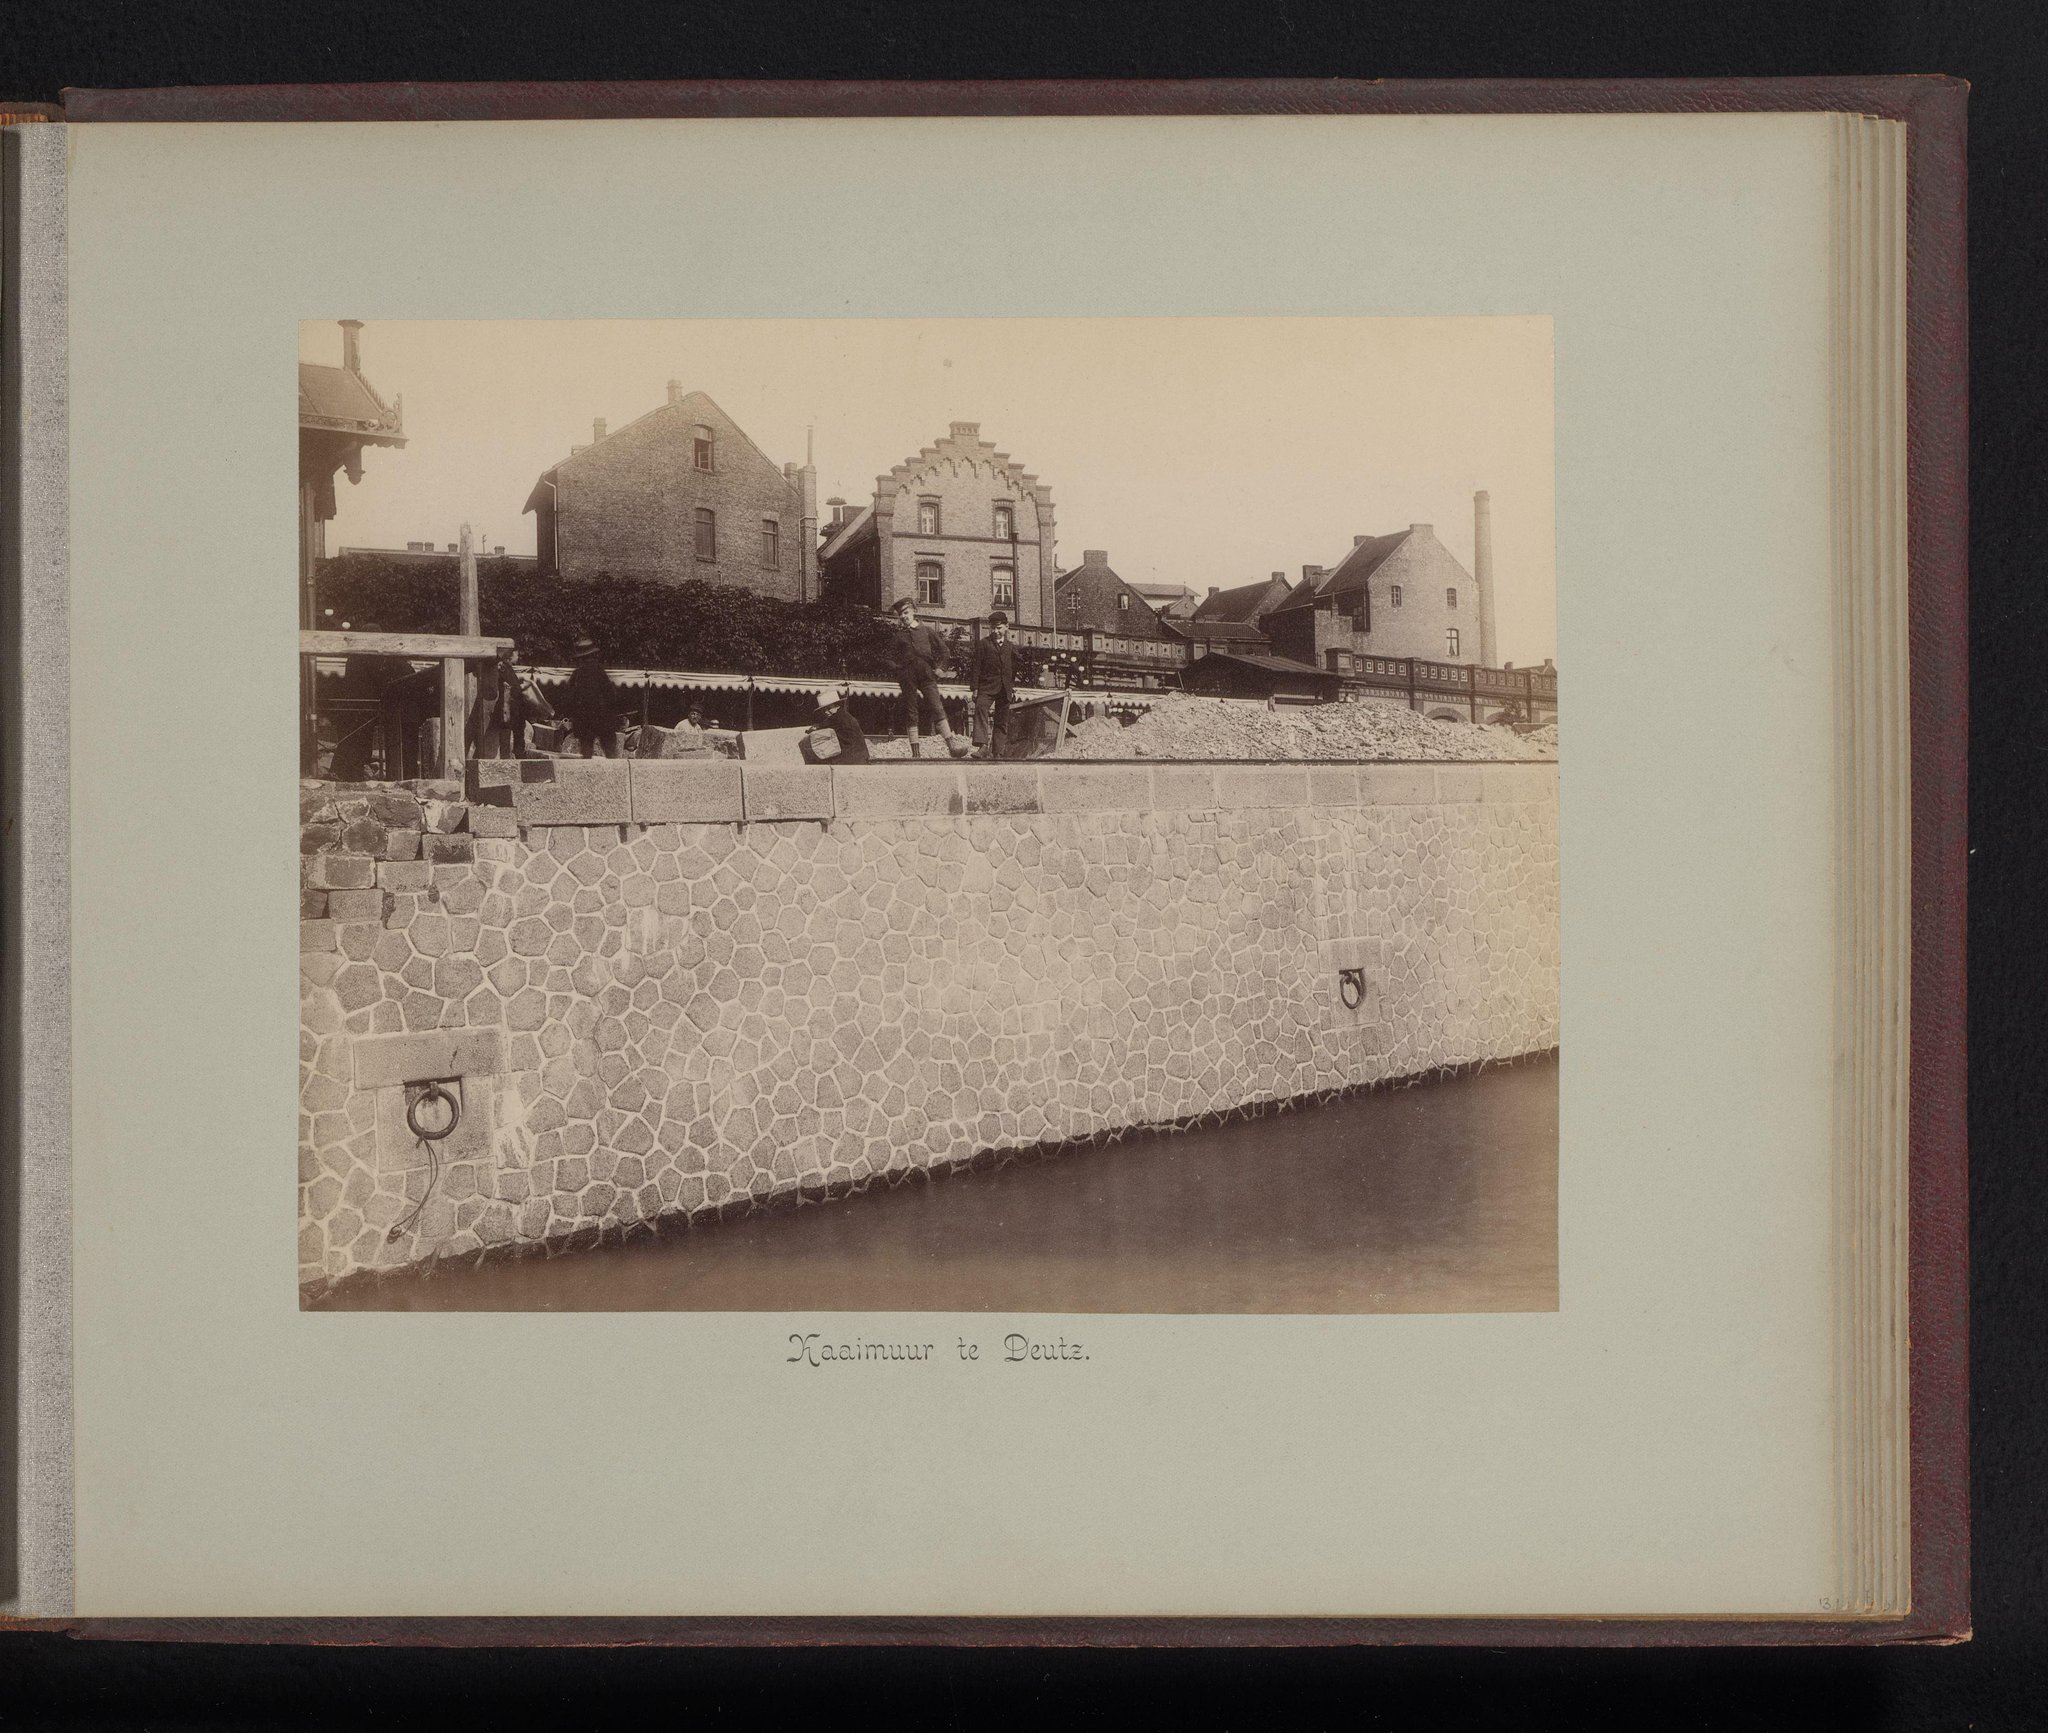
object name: album leaf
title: Twee mannen op een kaaimuur in Deutz, Duitsland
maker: Anonymous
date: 1883-1900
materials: cardboard, photographic support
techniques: albumen print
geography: deutz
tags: quay (+ city(-scape) with figures, staffage)